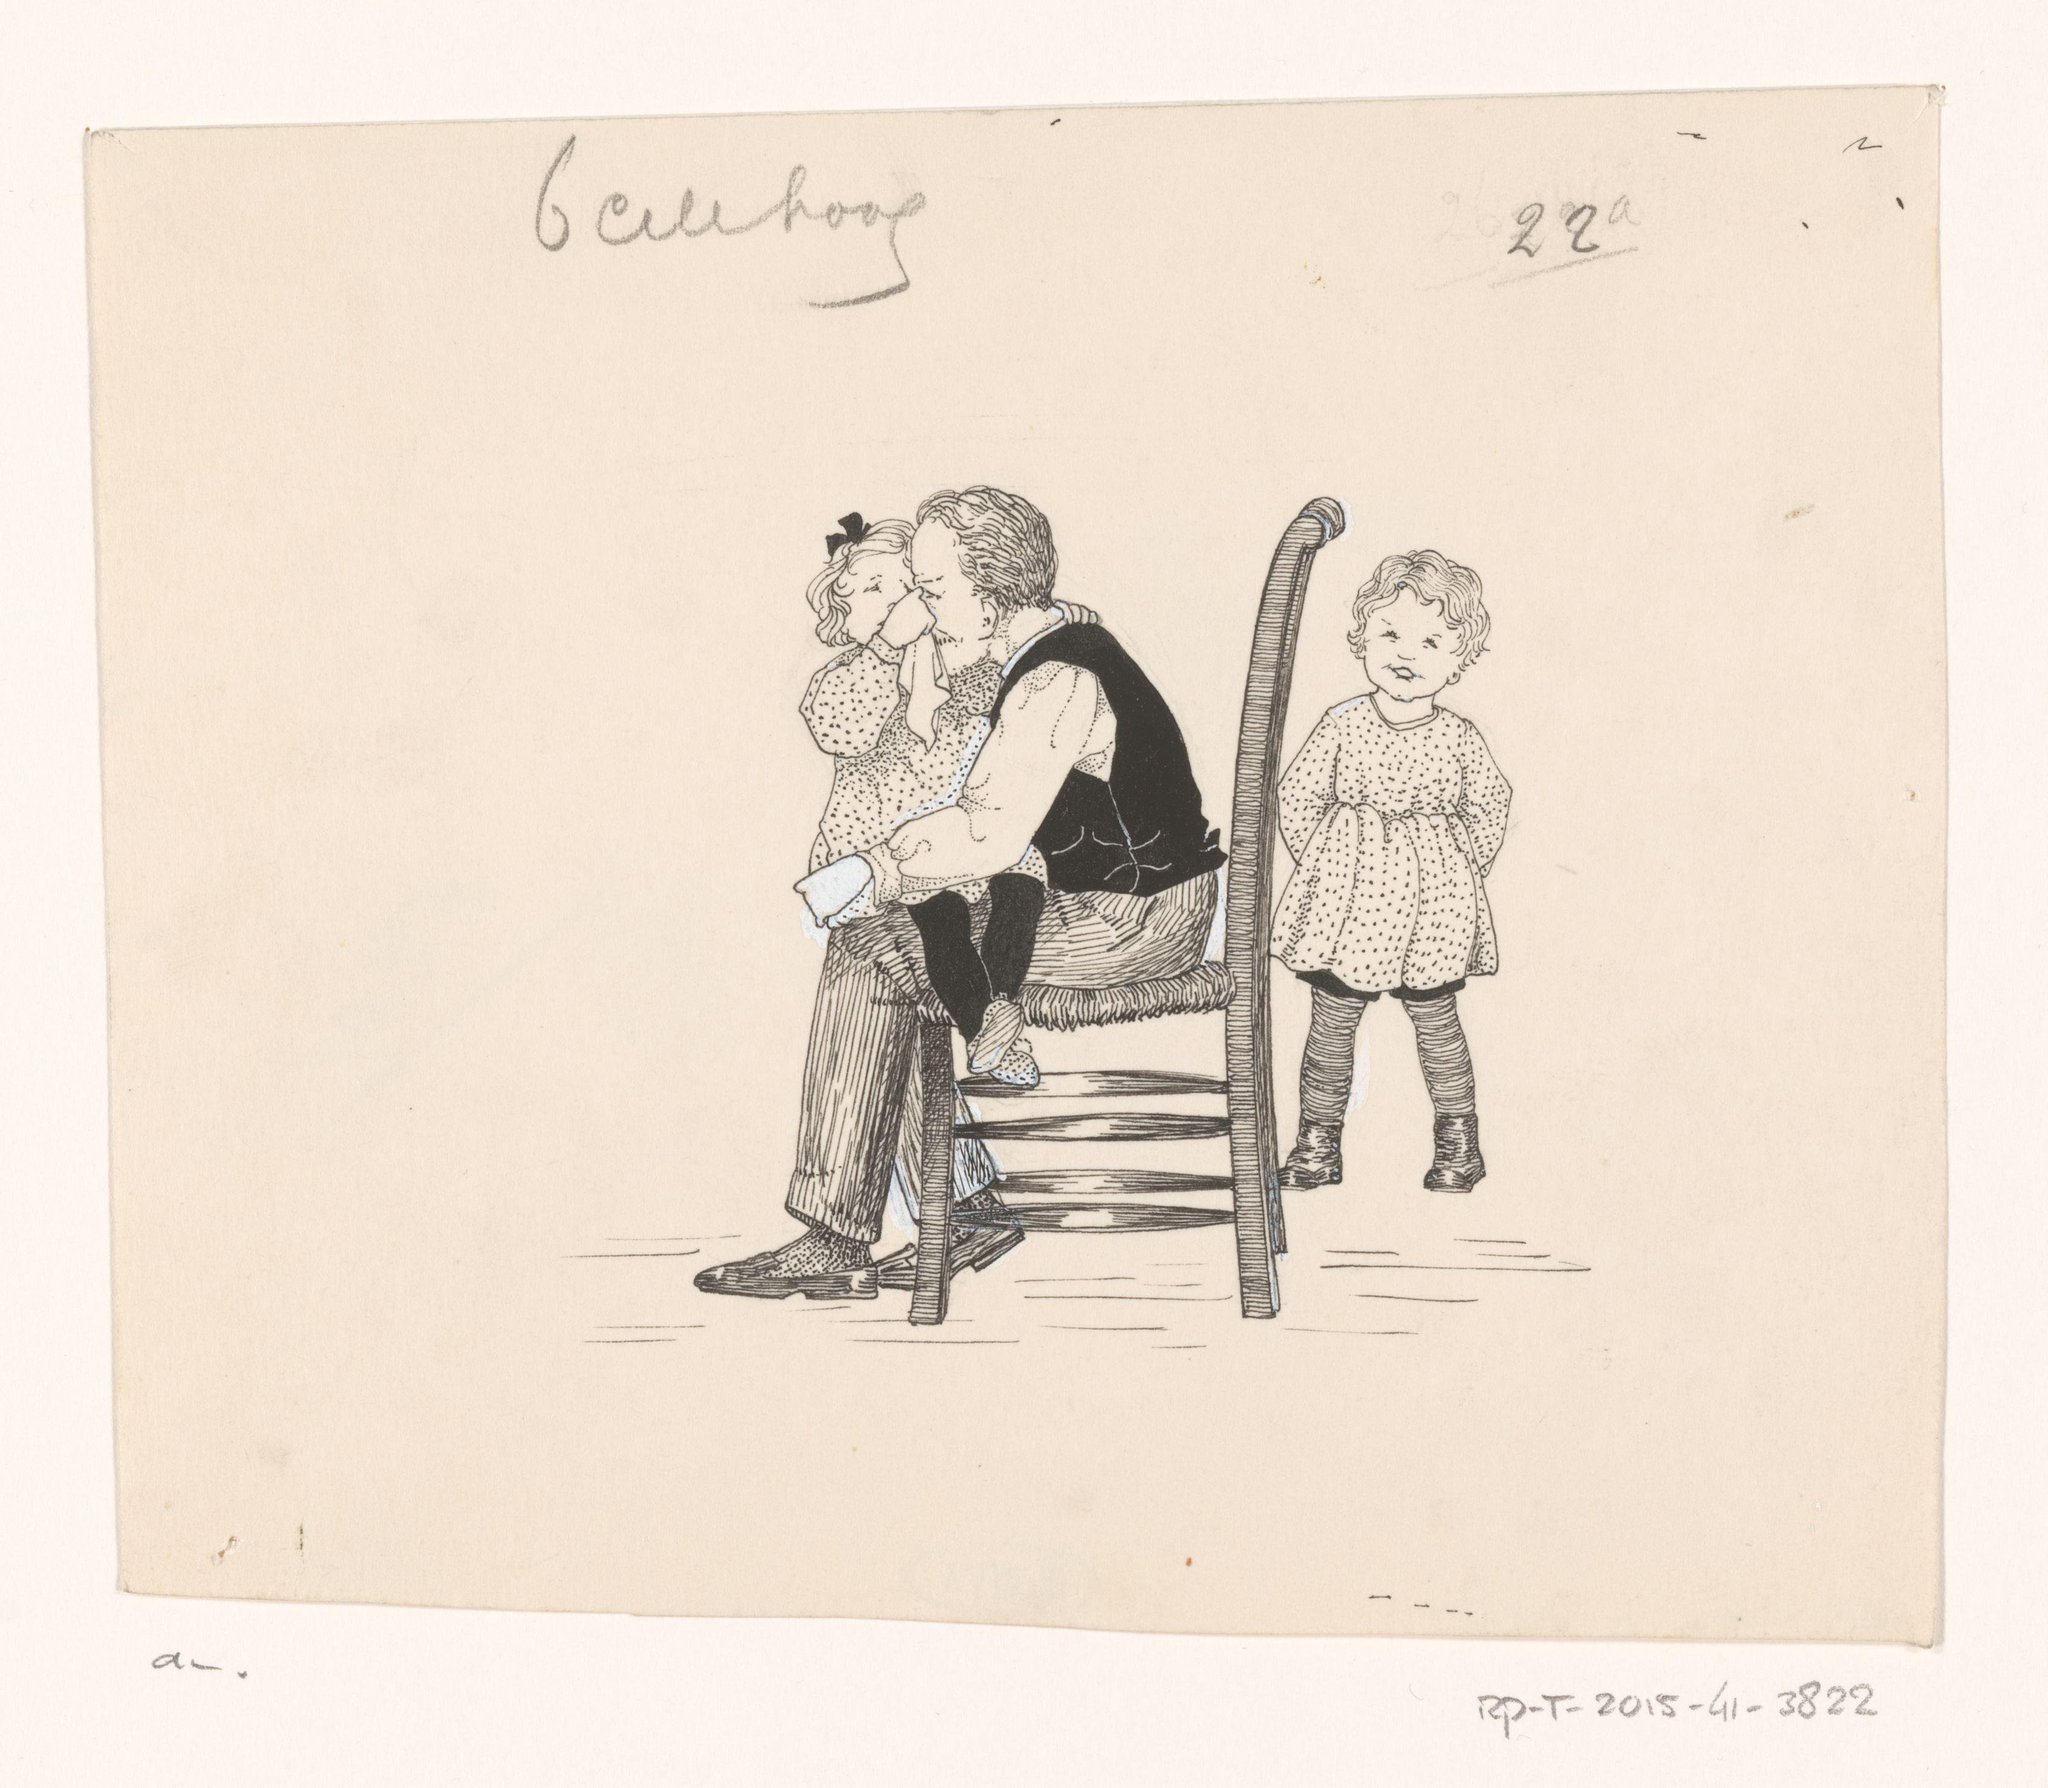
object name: drawing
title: Man troost huilend meisje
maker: Anonymous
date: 1890-1930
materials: paint, ink, paper, pencil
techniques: brush, pen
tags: childhood sorrows comforted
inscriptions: :, collector's mark: Lugt 2228a, number: ‘22a’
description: Een man zit op een stoel met een huilend meisje op schoot. Een tweede meisje staat ernaast.